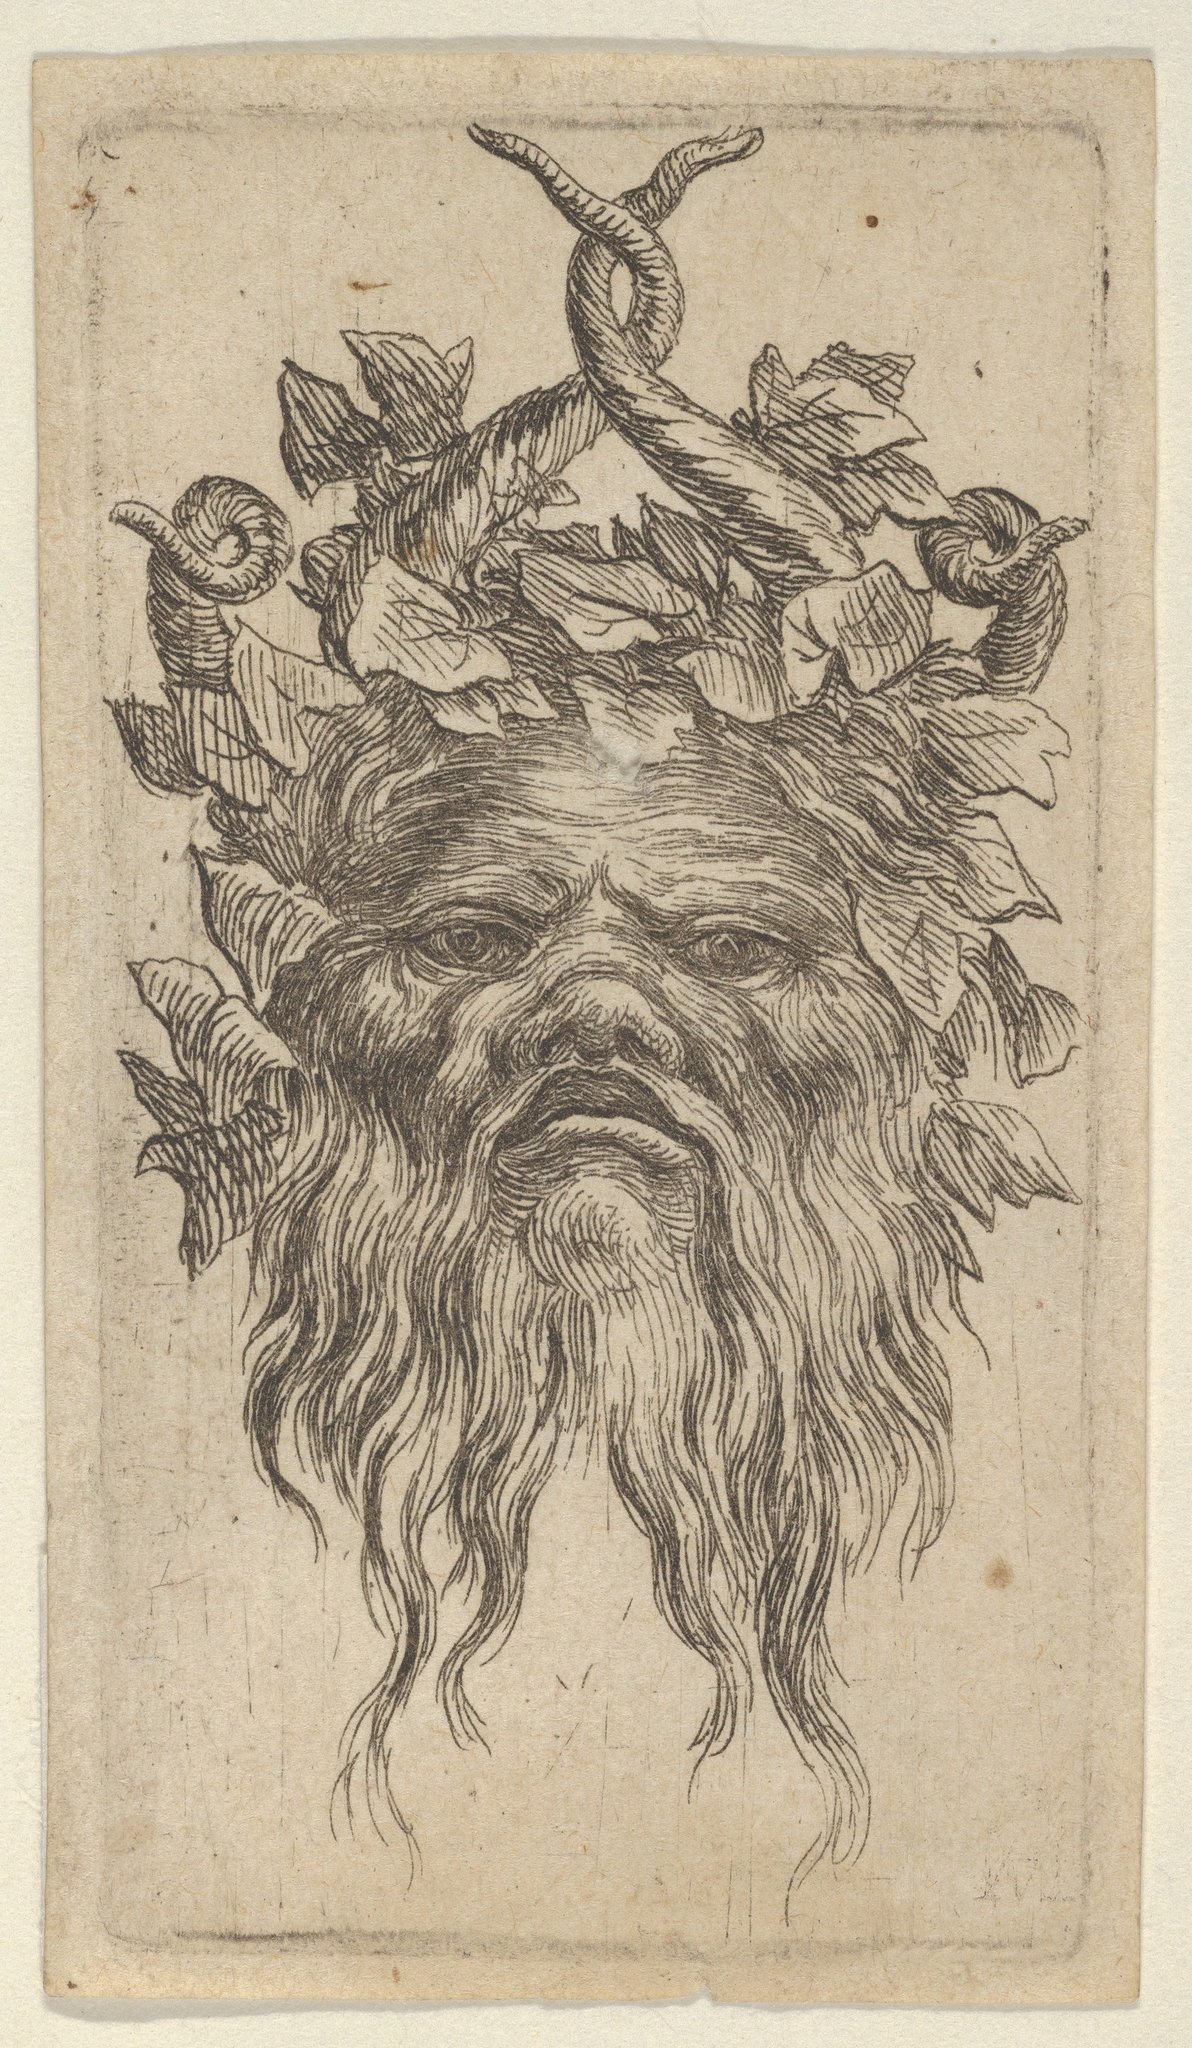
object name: print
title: Satyr Mask with Hooked Horns and an Ivy Wreath, from "Divers Masques"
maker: françois chauveau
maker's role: artist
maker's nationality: french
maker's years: 1613-1676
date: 1635-1645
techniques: etching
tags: masks